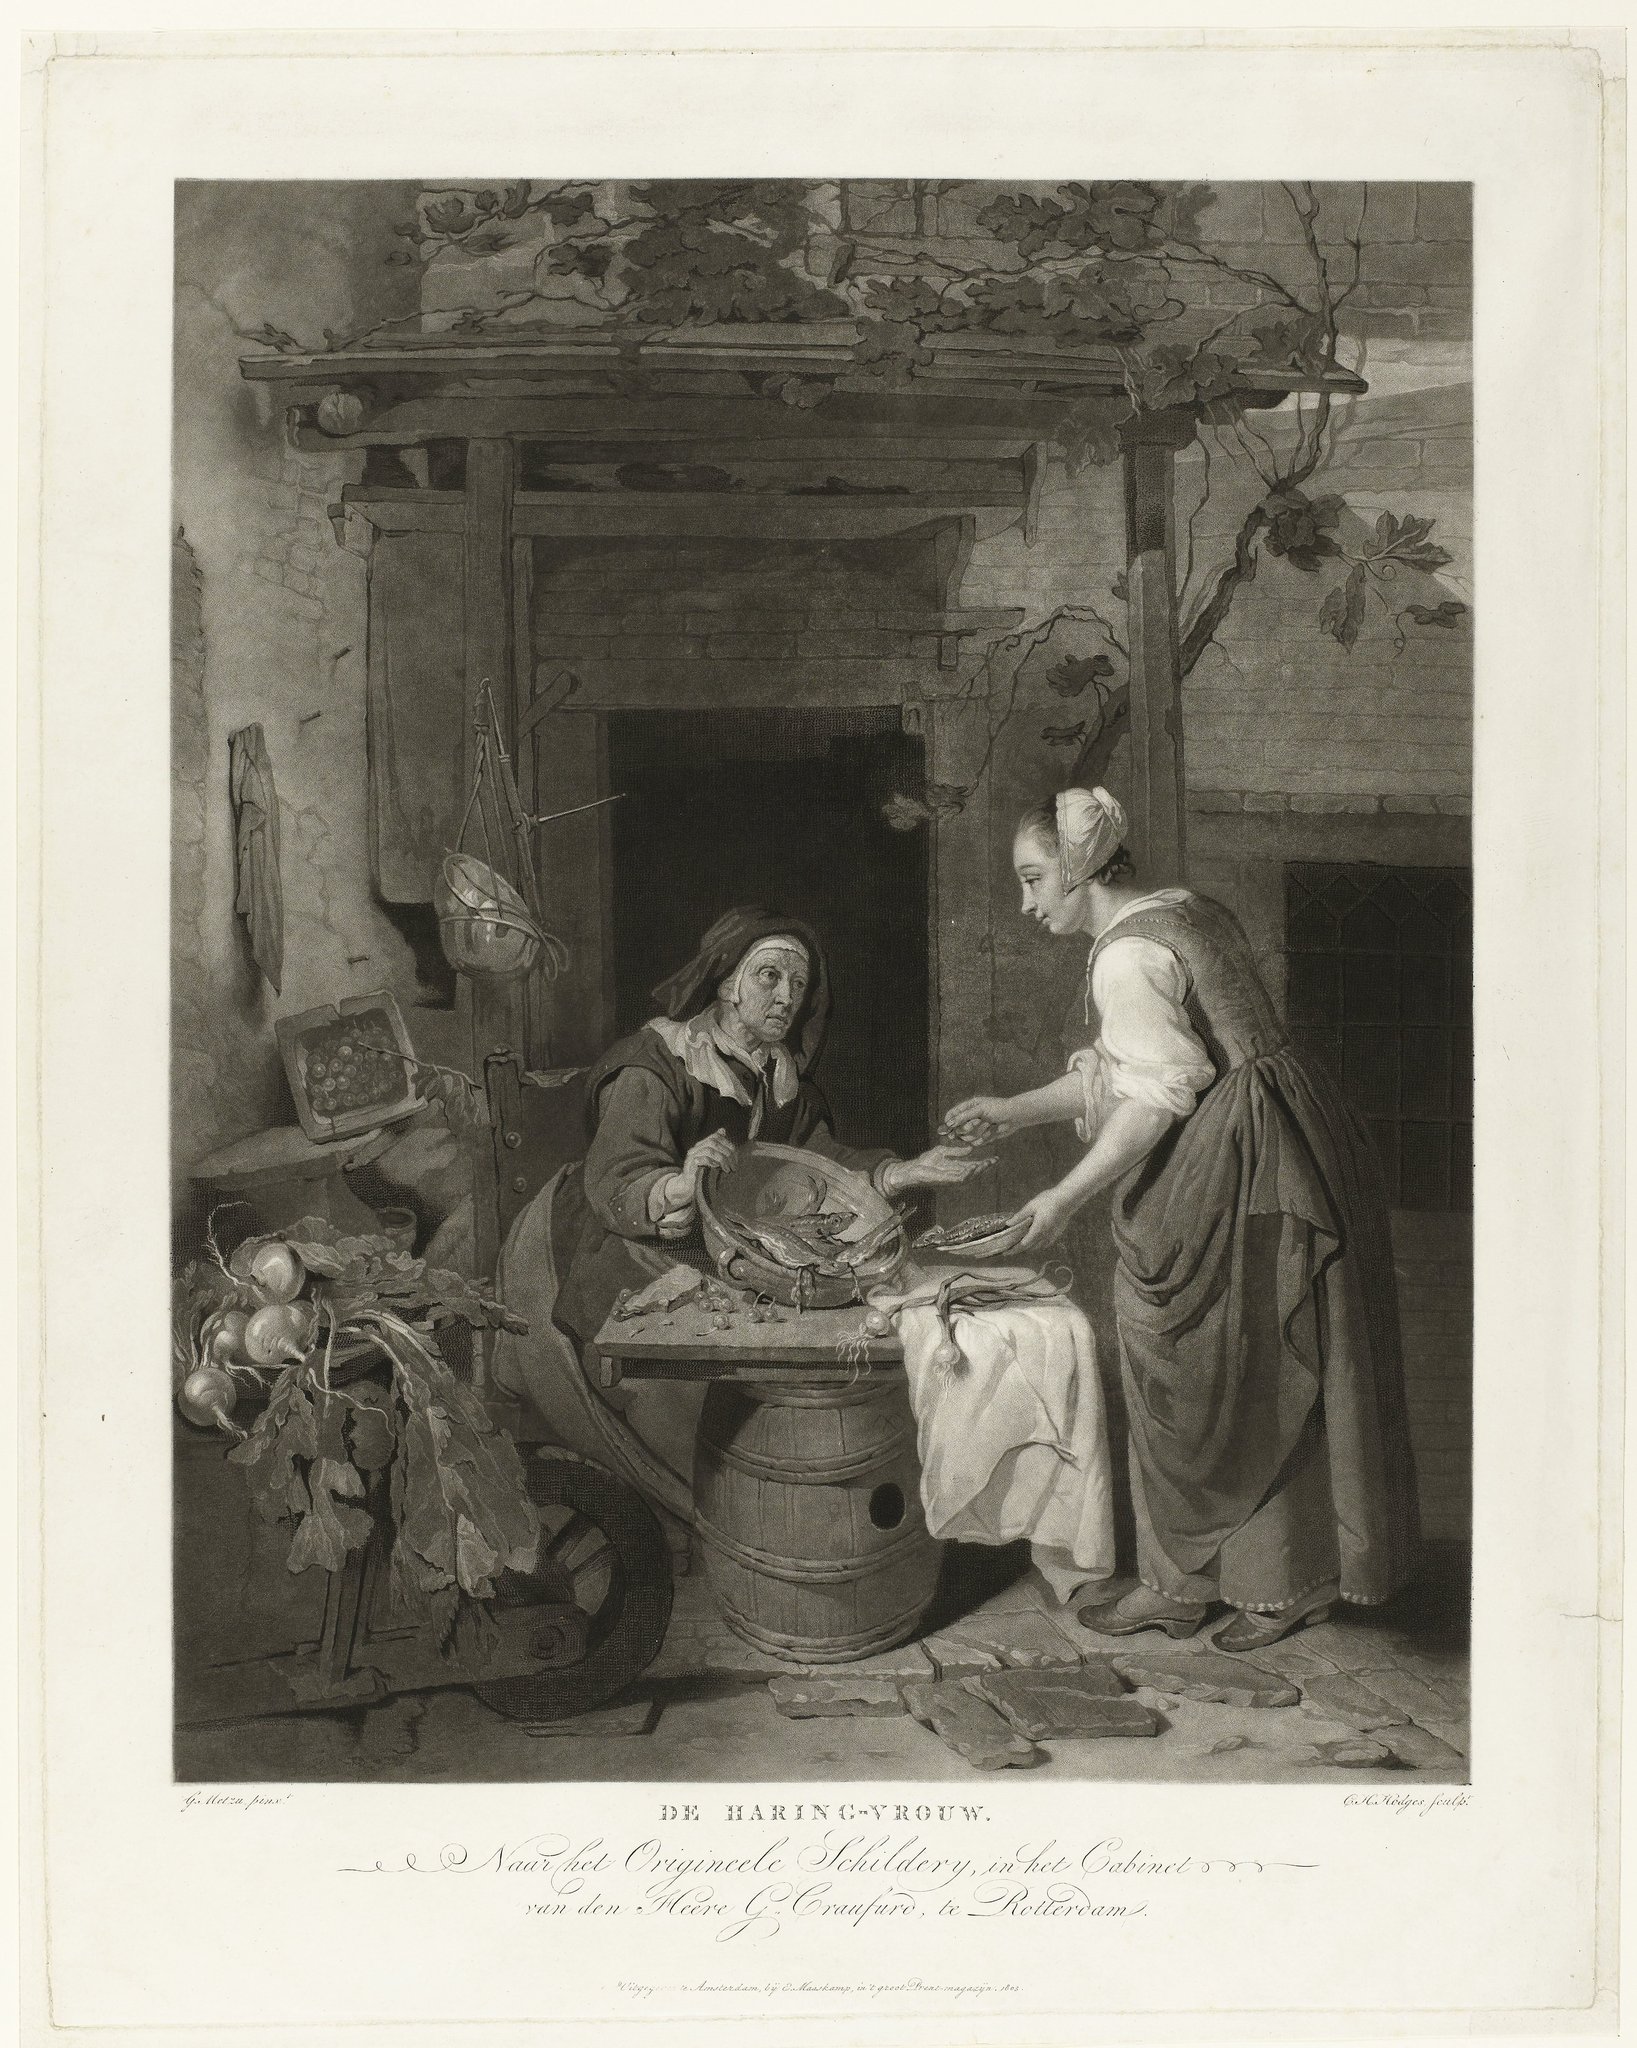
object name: print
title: Haringverkoopster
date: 1803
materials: paper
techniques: etching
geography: amsterdam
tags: bony fishes: herring, (non-fruit) products of plants or trees: onion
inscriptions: collector's mark: Lugt 2228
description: Voor de ingang van een huis verkoopt een oude vrouw haringen aan een dienstmeid.